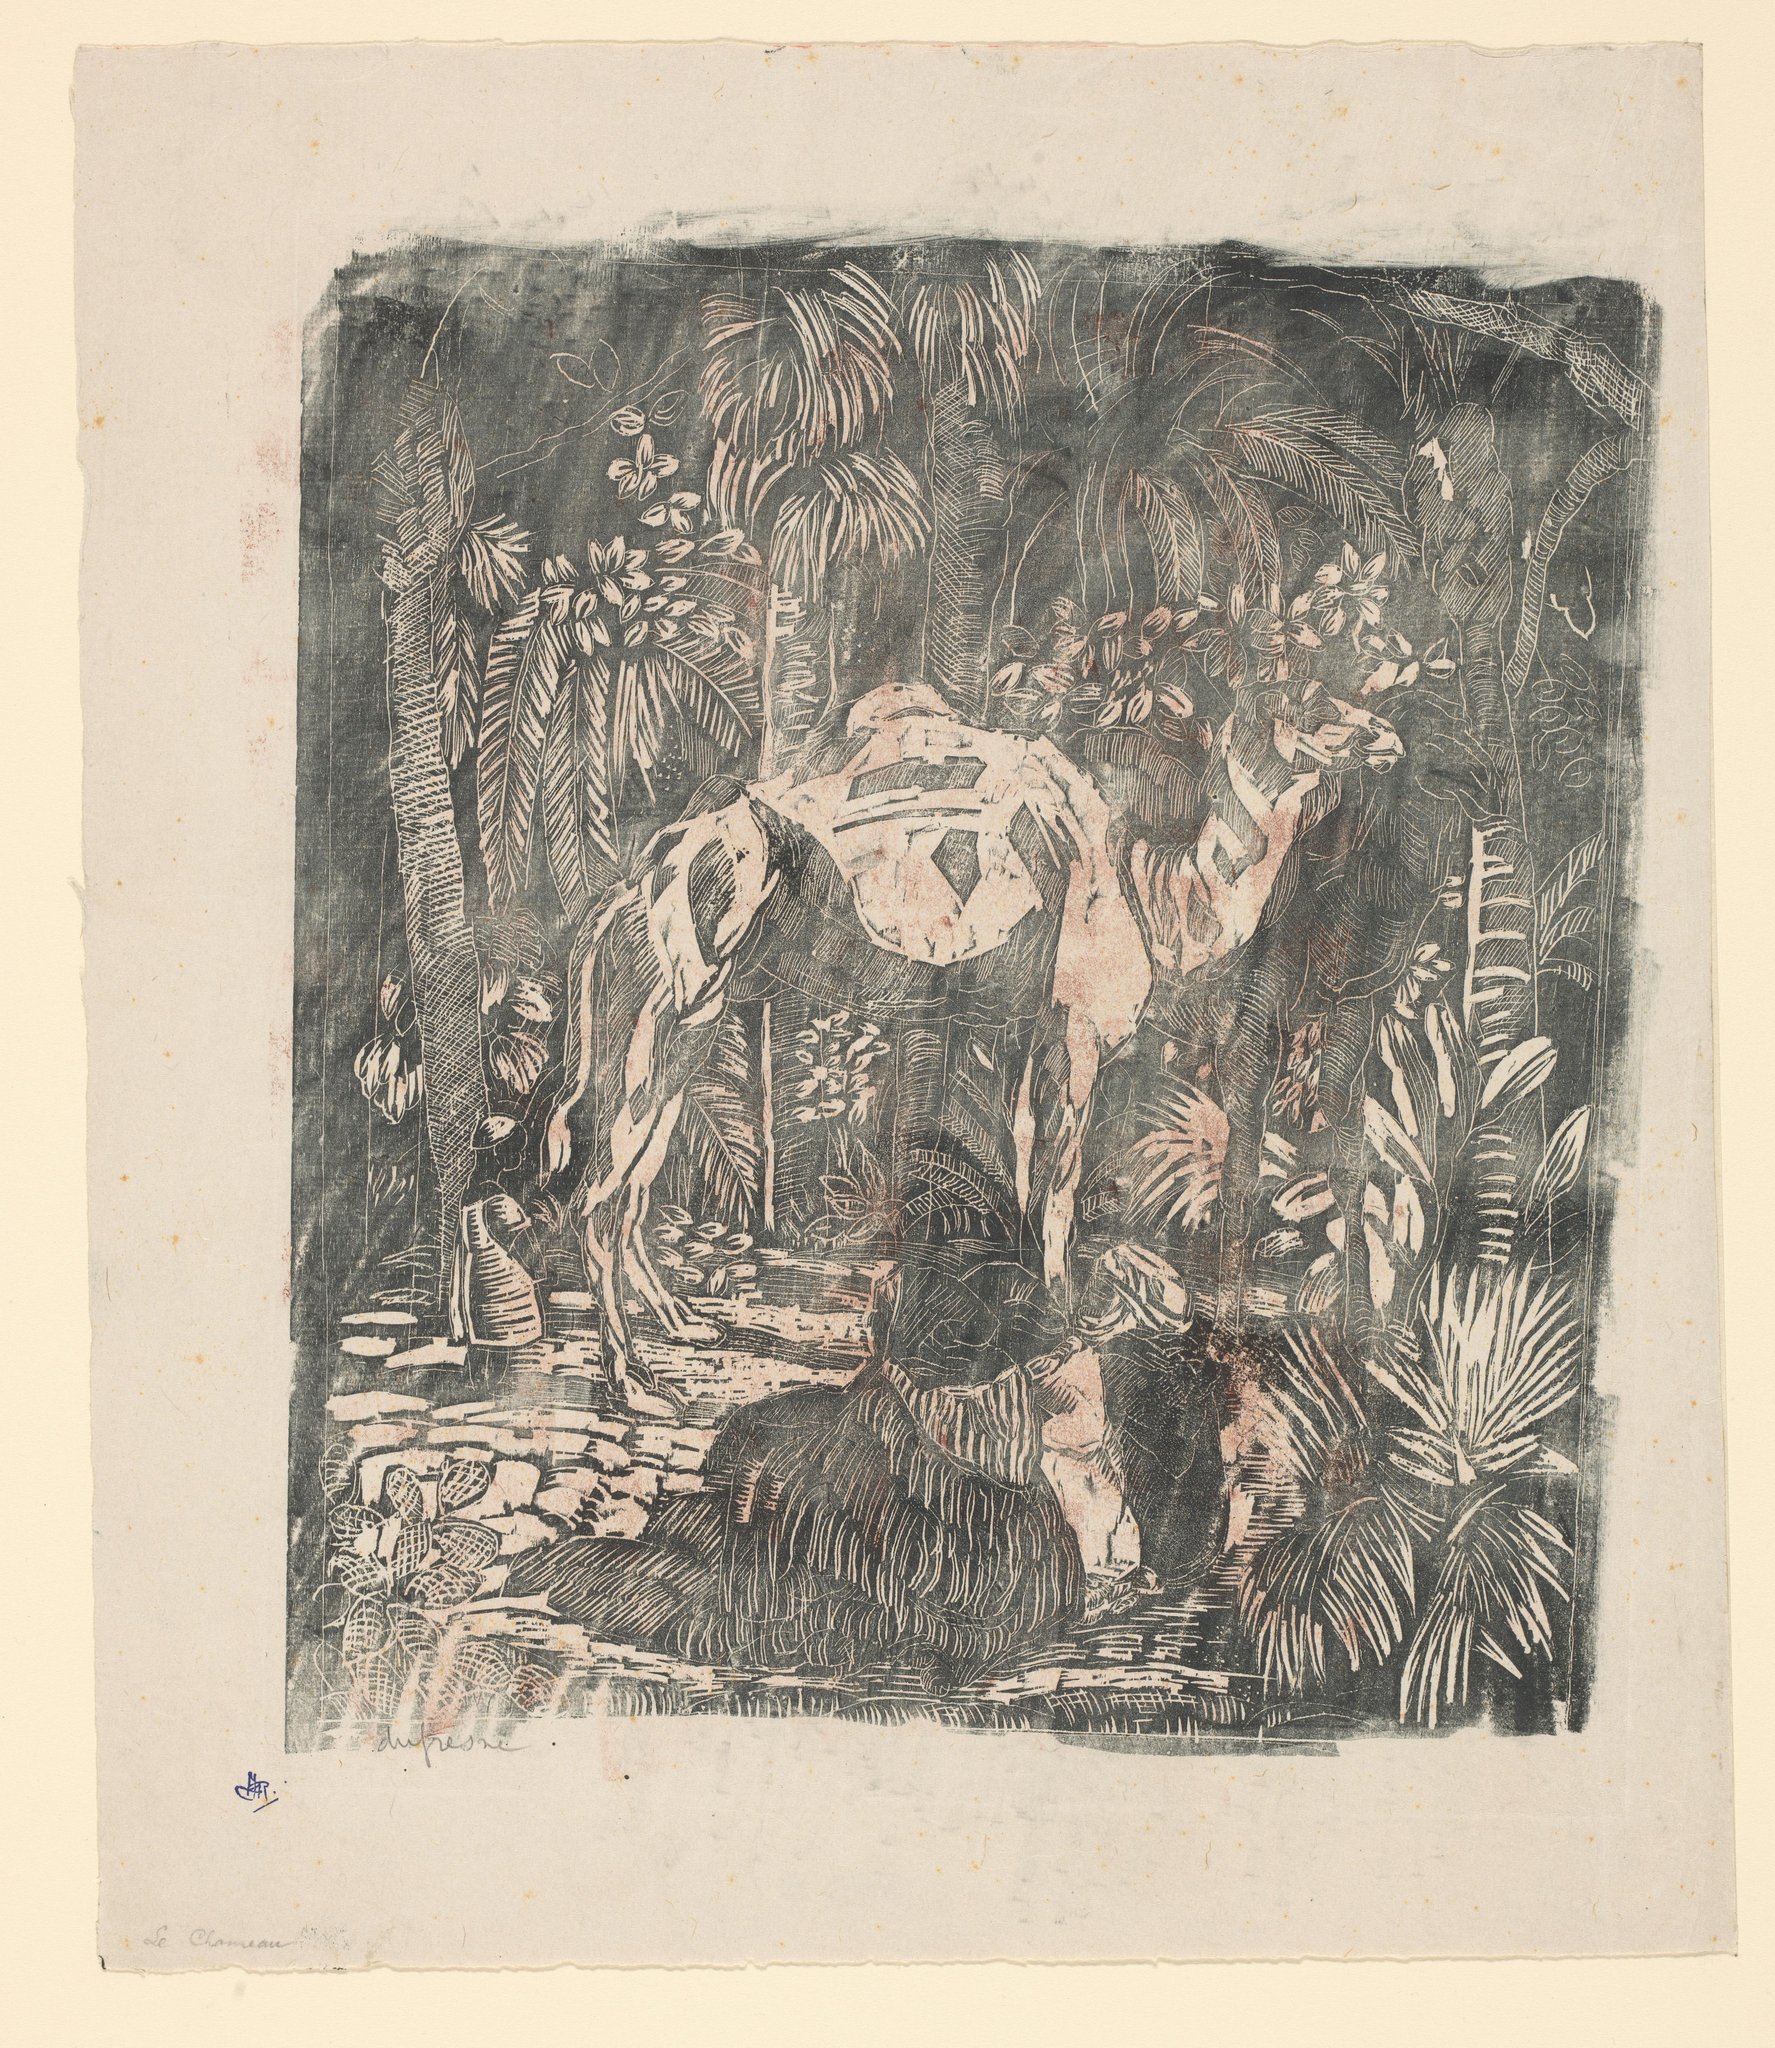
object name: print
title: Le chameau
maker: charles dufresne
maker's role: print maker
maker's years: 1876-1938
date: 1912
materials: paper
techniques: woodcut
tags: hoofed animals: camel, head-gear: turban, jungle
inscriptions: collector's mark: Lugt 1516a, collector's mark: Lugt 2760, collector's mark: Lugt 2228